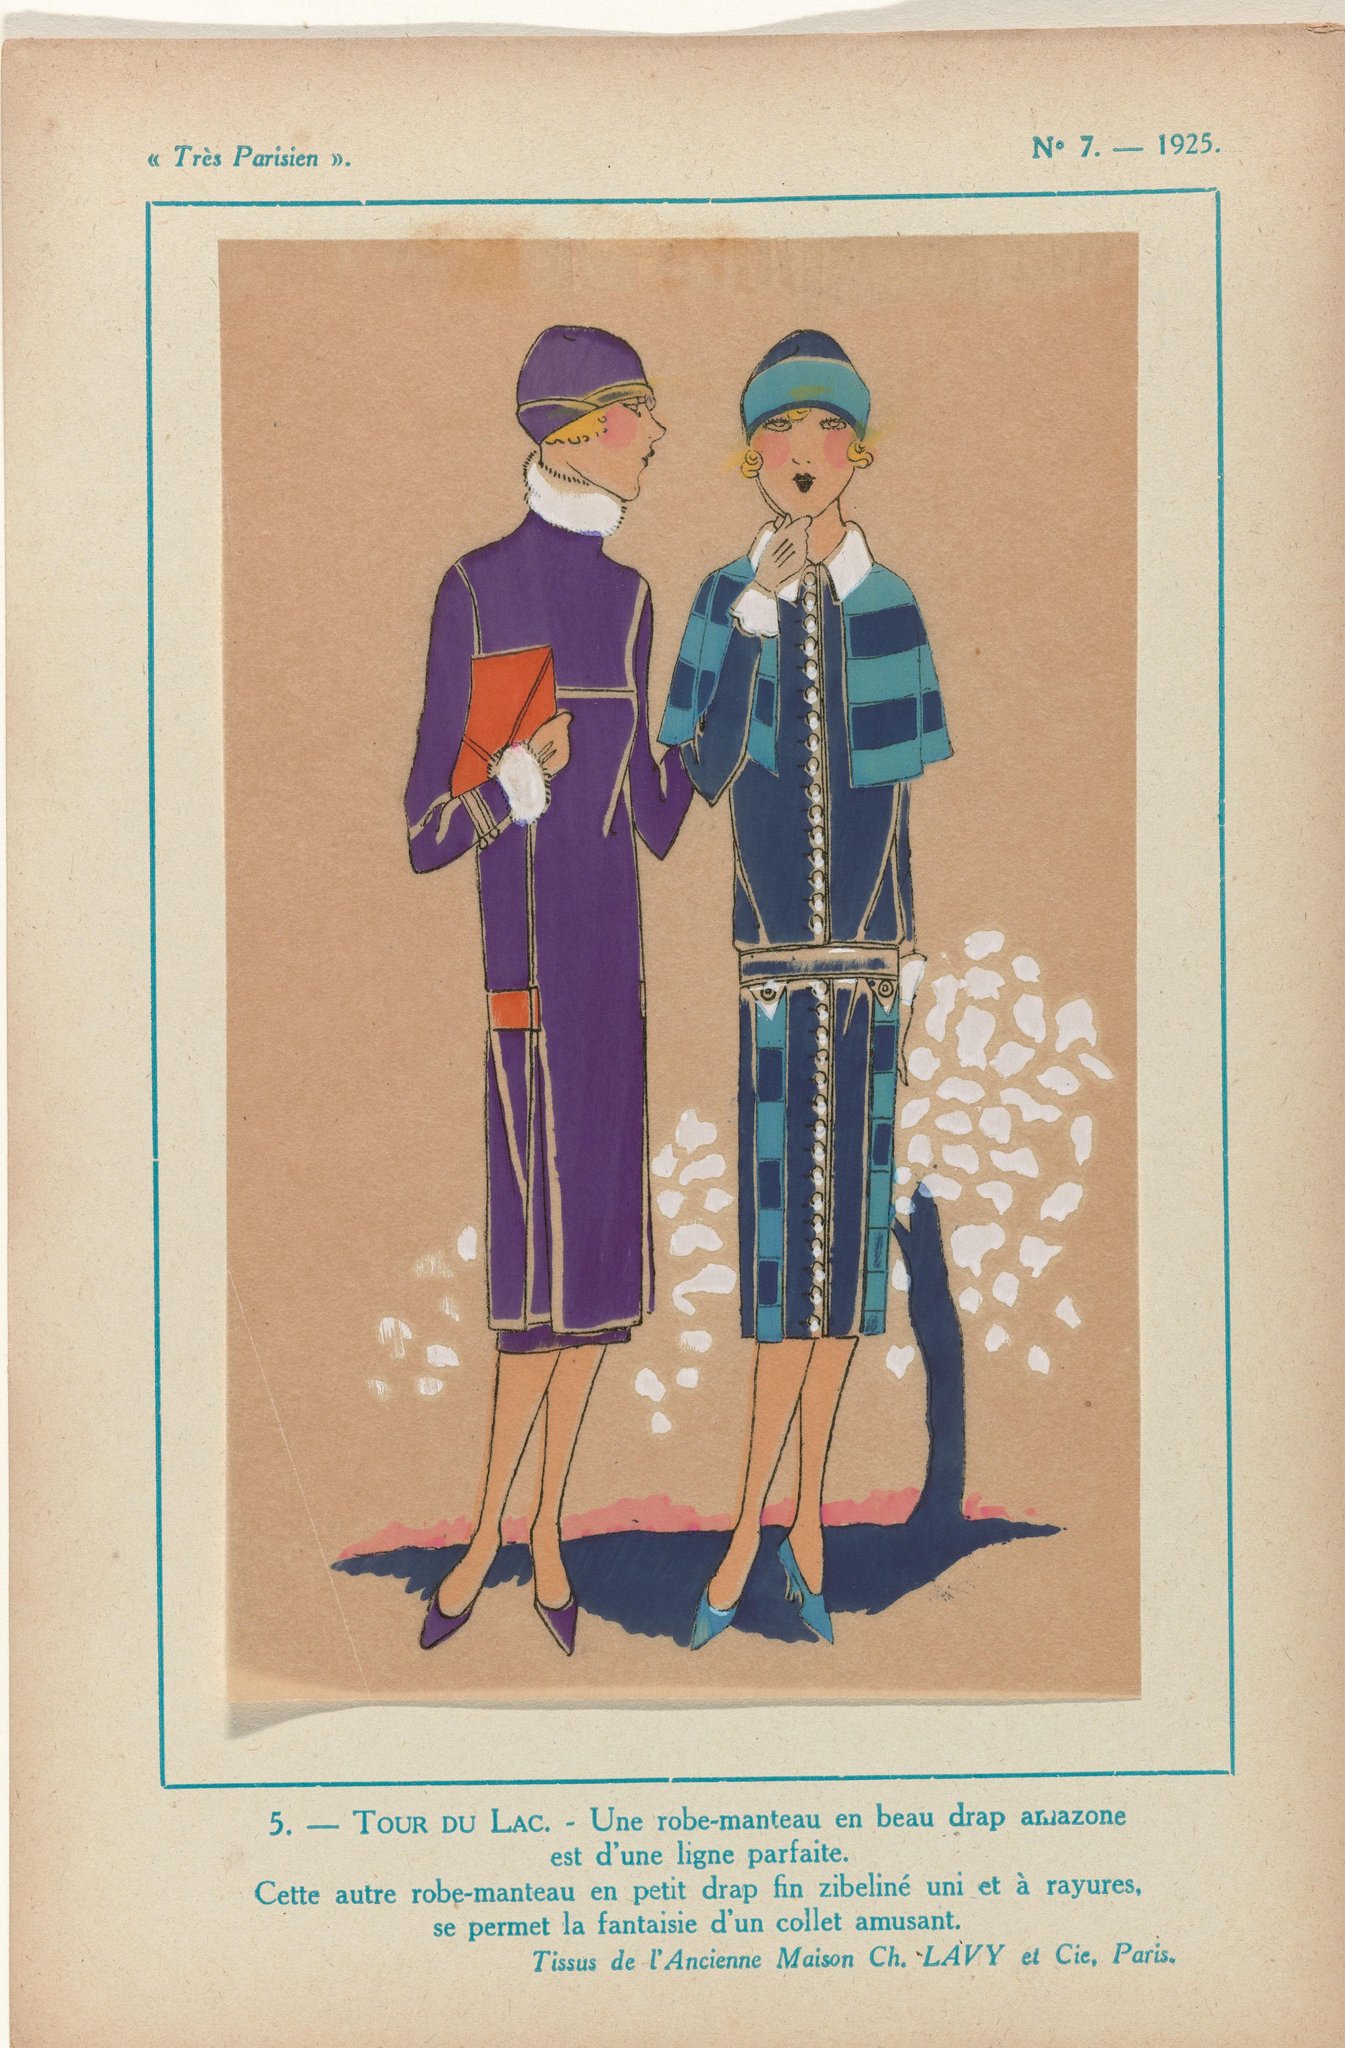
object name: fashion print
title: Très Parisien, 1925, No. 7, Pl. 5. - TOUR DU LAC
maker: g-p. joumard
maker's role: publisher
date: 1925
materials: paper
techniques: hand coloring, letterpress printing, lithography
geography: paris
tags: bag (clutch) (+ women's clothes), fashion plates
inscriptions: caption: ‘5. - TOUR DU LAC. - Une robe-manteau en beau drap amazone est d'une ligne parfaite. Cette autre robe-manteau en petit drap fin zibeliné uni et à rayures, se permet la fantaisie d'un collet amusant. Tissus de l'Ancienne Maison Ch. LAVY et Cie, Paris.’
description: Twee 'robe-manteaux'. Stoffen van Ch. Lavy, Parijs. Prent uit het modetijdschrift Très Parisien...La Mode, Le Chic, L'Élégance (1920-1936)